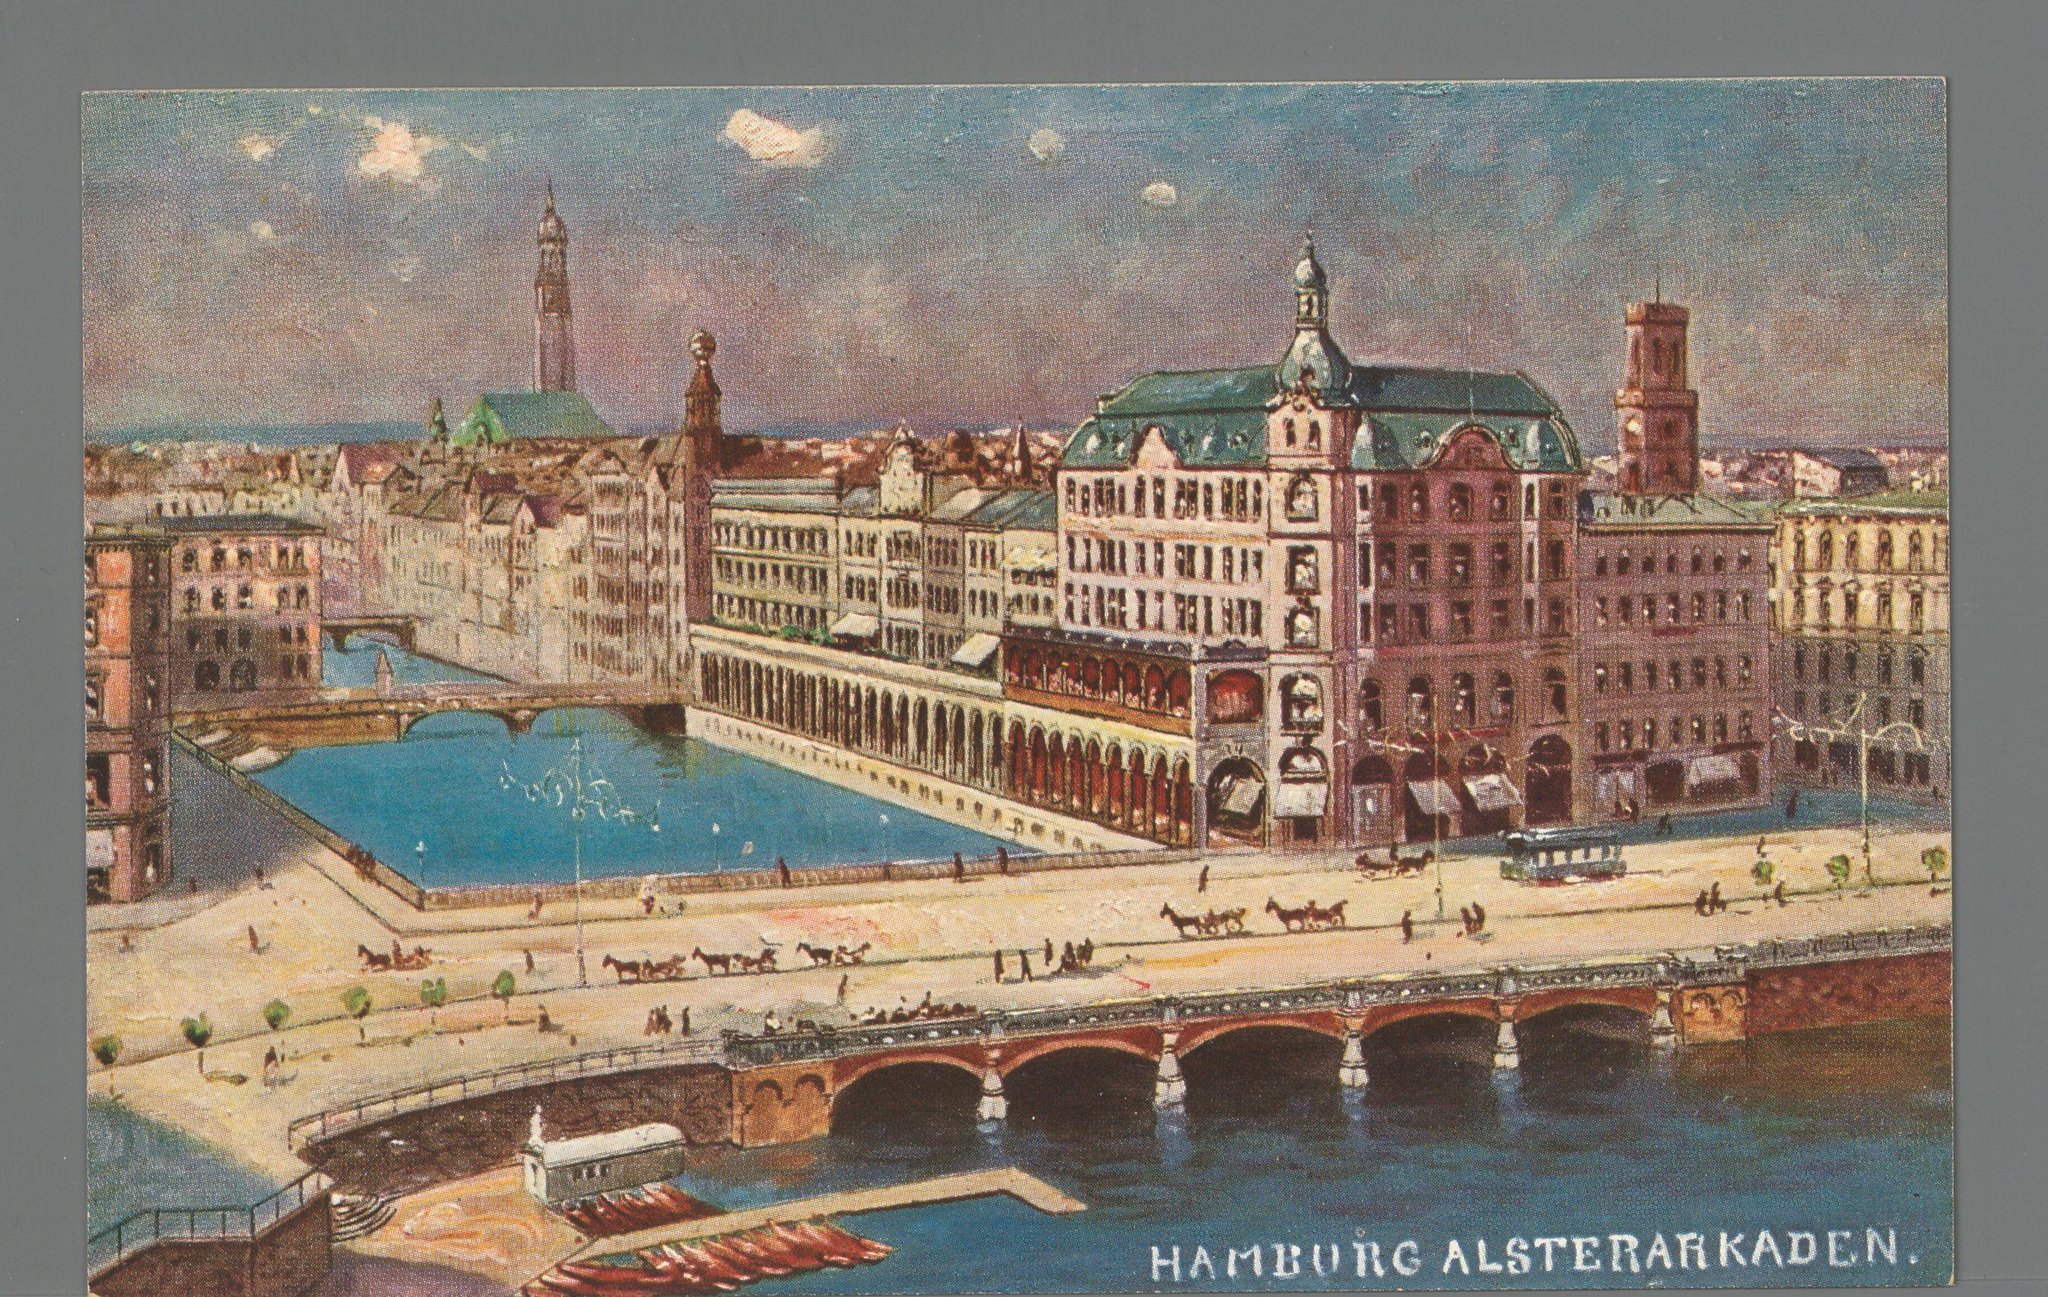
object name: ansichtkaart, prentbriefkaart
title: Hamburg. Alsterarkaden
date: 1905-1930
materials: cardboard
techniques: color autotype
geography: nuremberg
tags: city-view, and landscape with man-made constructions, canals, waters (in city), bridge in city across river, canal, etc.